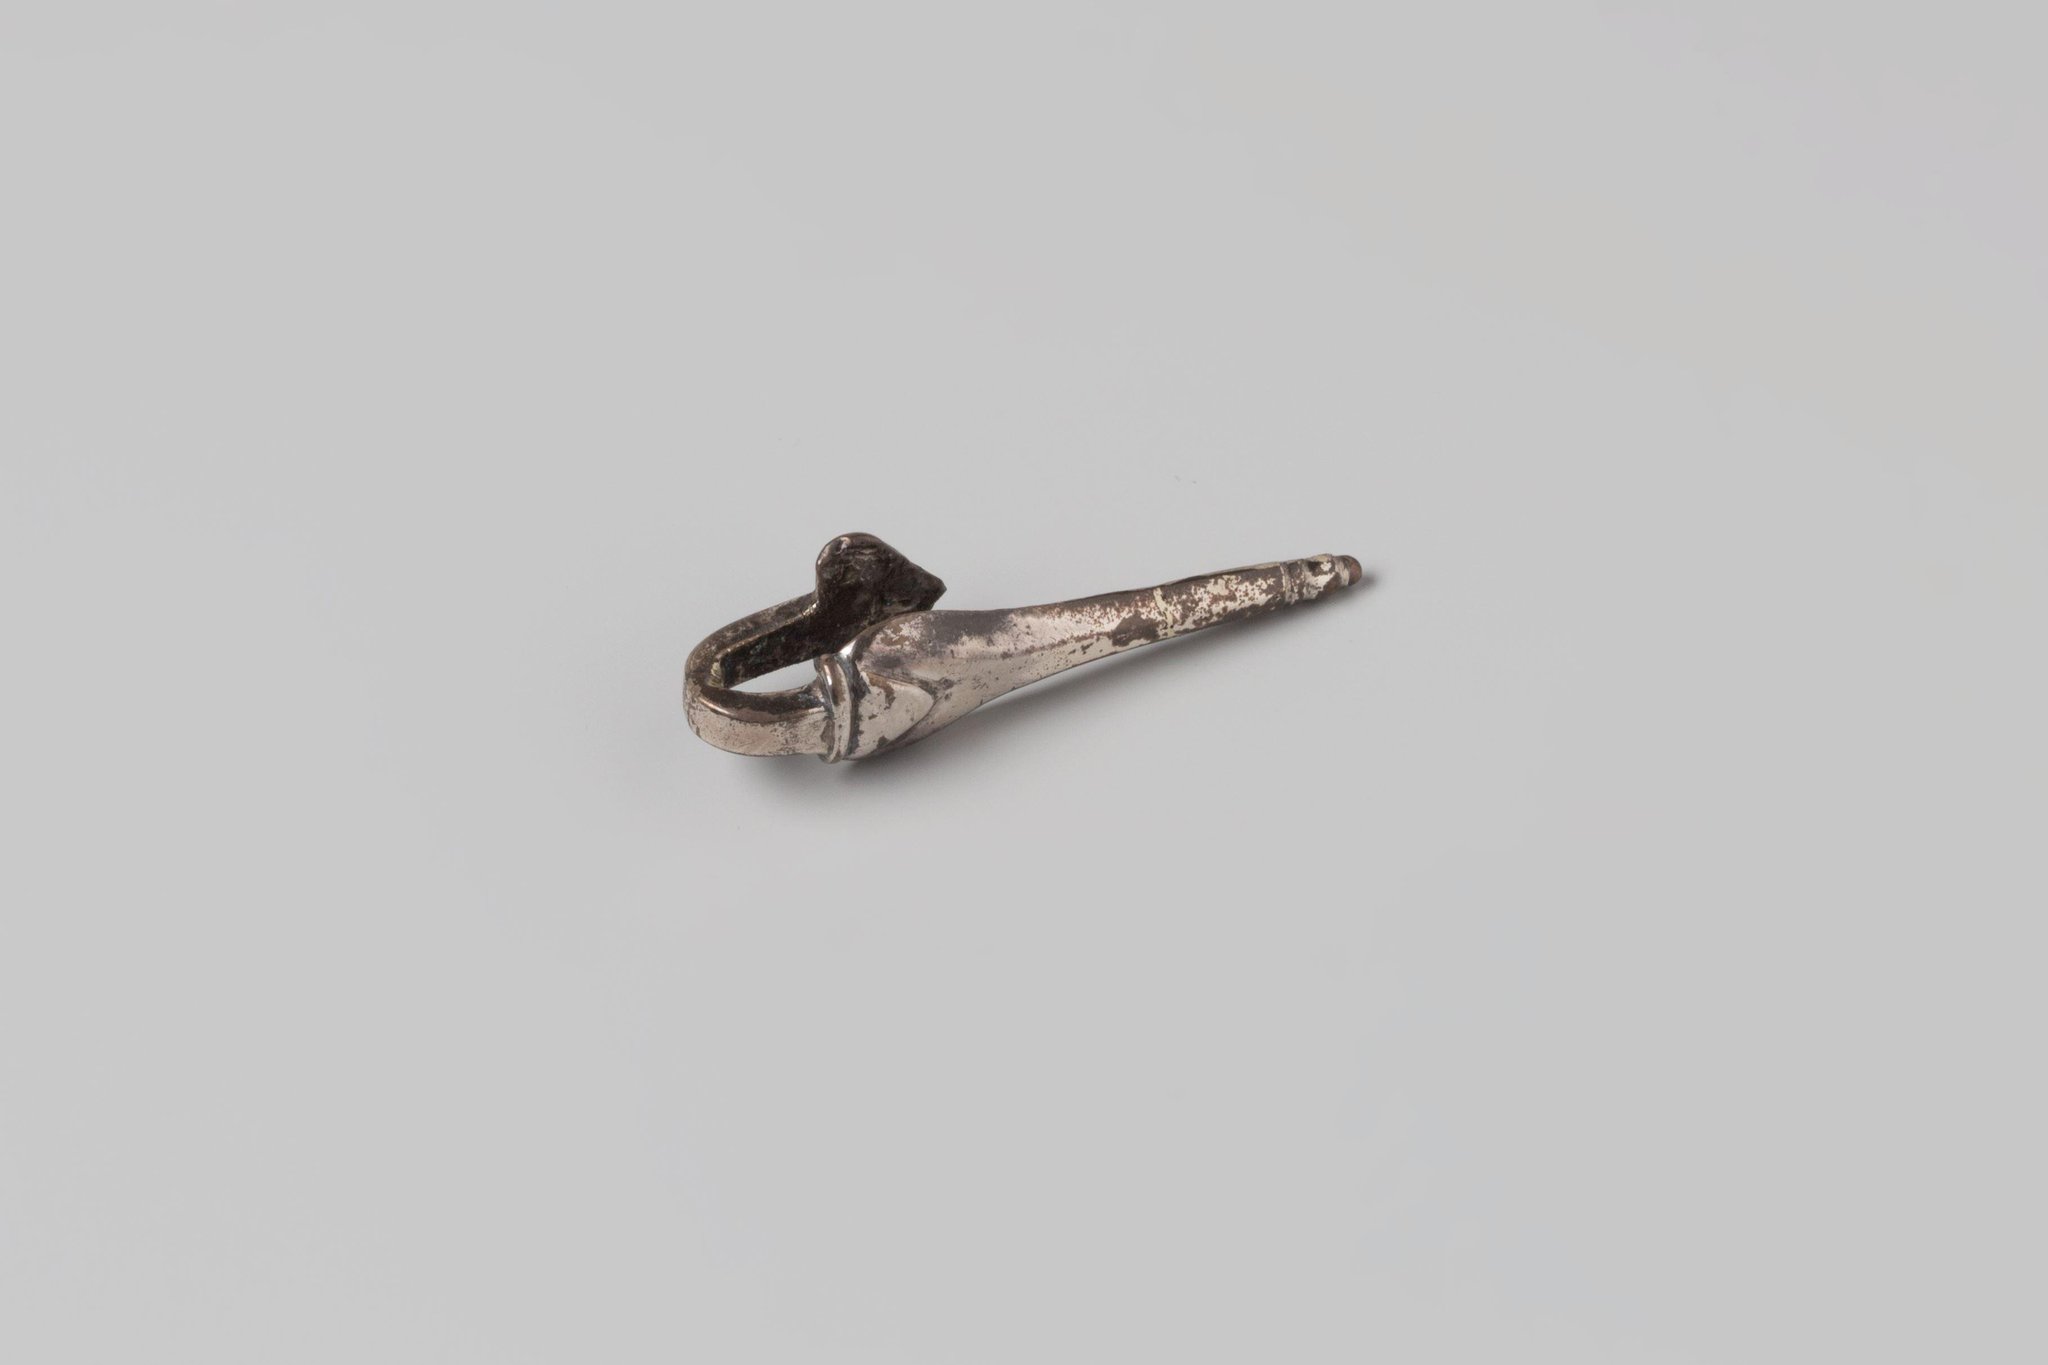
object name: knife with sheath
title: Clip van schede uit het wrak van de Oost-Indiëvaarder Hollandia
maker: Anonymous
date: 1700-1743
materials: silver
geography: netherlands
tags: verenigde oostindische compagnie, hollandia (schip), annet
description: Fragm, tapering tongue with single drop pattern, looped top with heart-shaped end, 2 marks legible [coat of arms of Amsterdam, HDF].